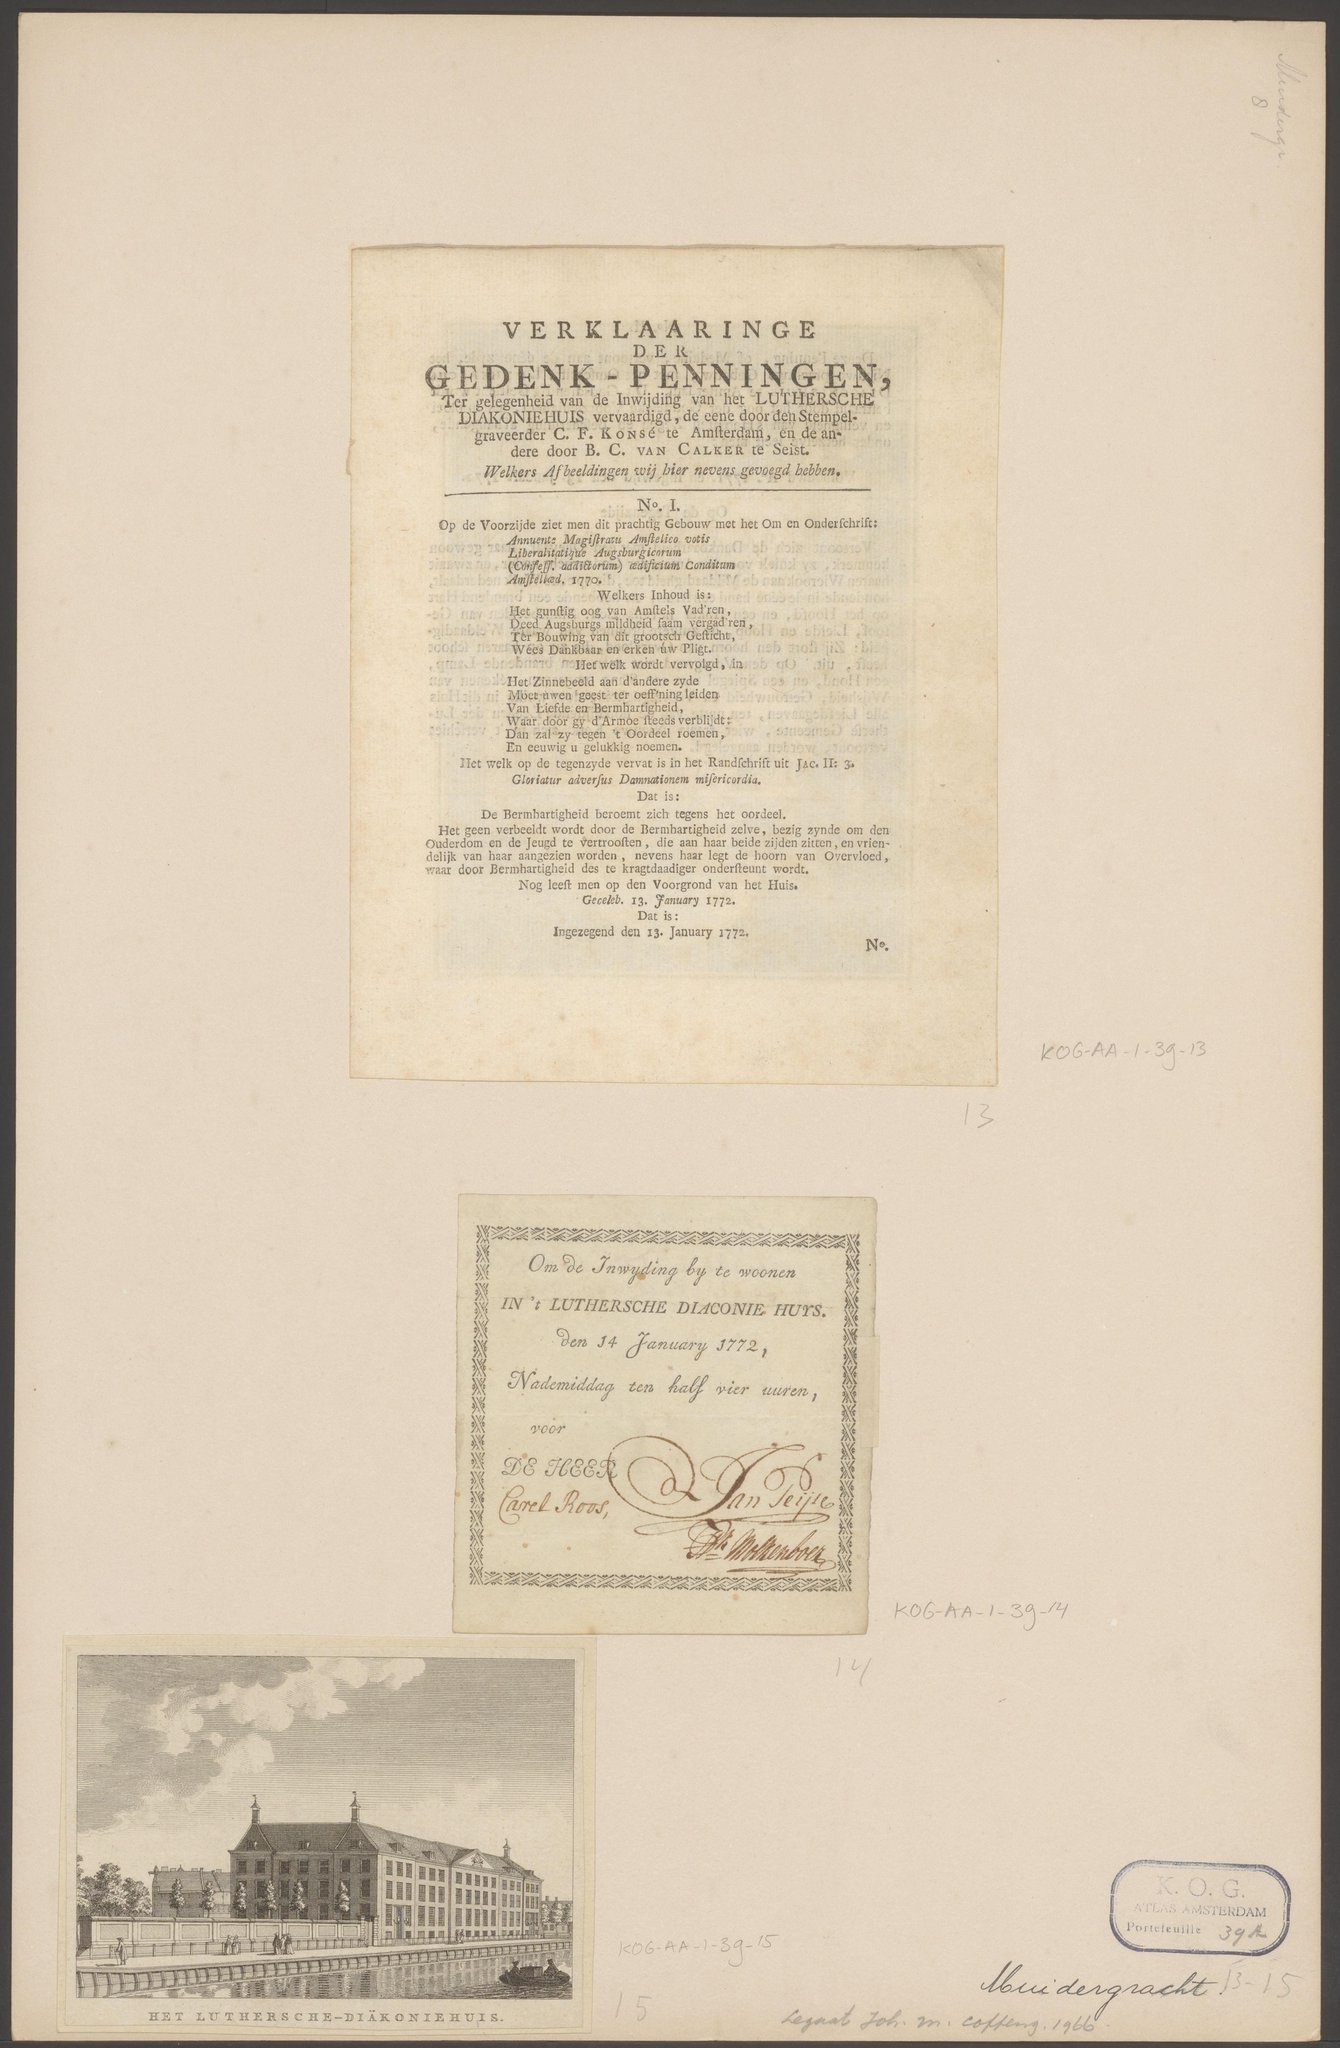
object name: print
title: Gezicht op het Lutherse Diaconiehuis te Amsterdam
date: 1789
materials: paper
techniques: etching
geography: amsterdam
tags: canals, waters (in city) (+ city(-scape) with figures, staffage), old-people's home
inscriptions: collector's mark: Lugt 1641b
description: Onderwerpsrubriek binnen de Atlas Amsterdam: Armwezen en liefdadige instellingen: II. Kerkelijke inrichtingen: Inrichtingen der Evang. Luthersen.